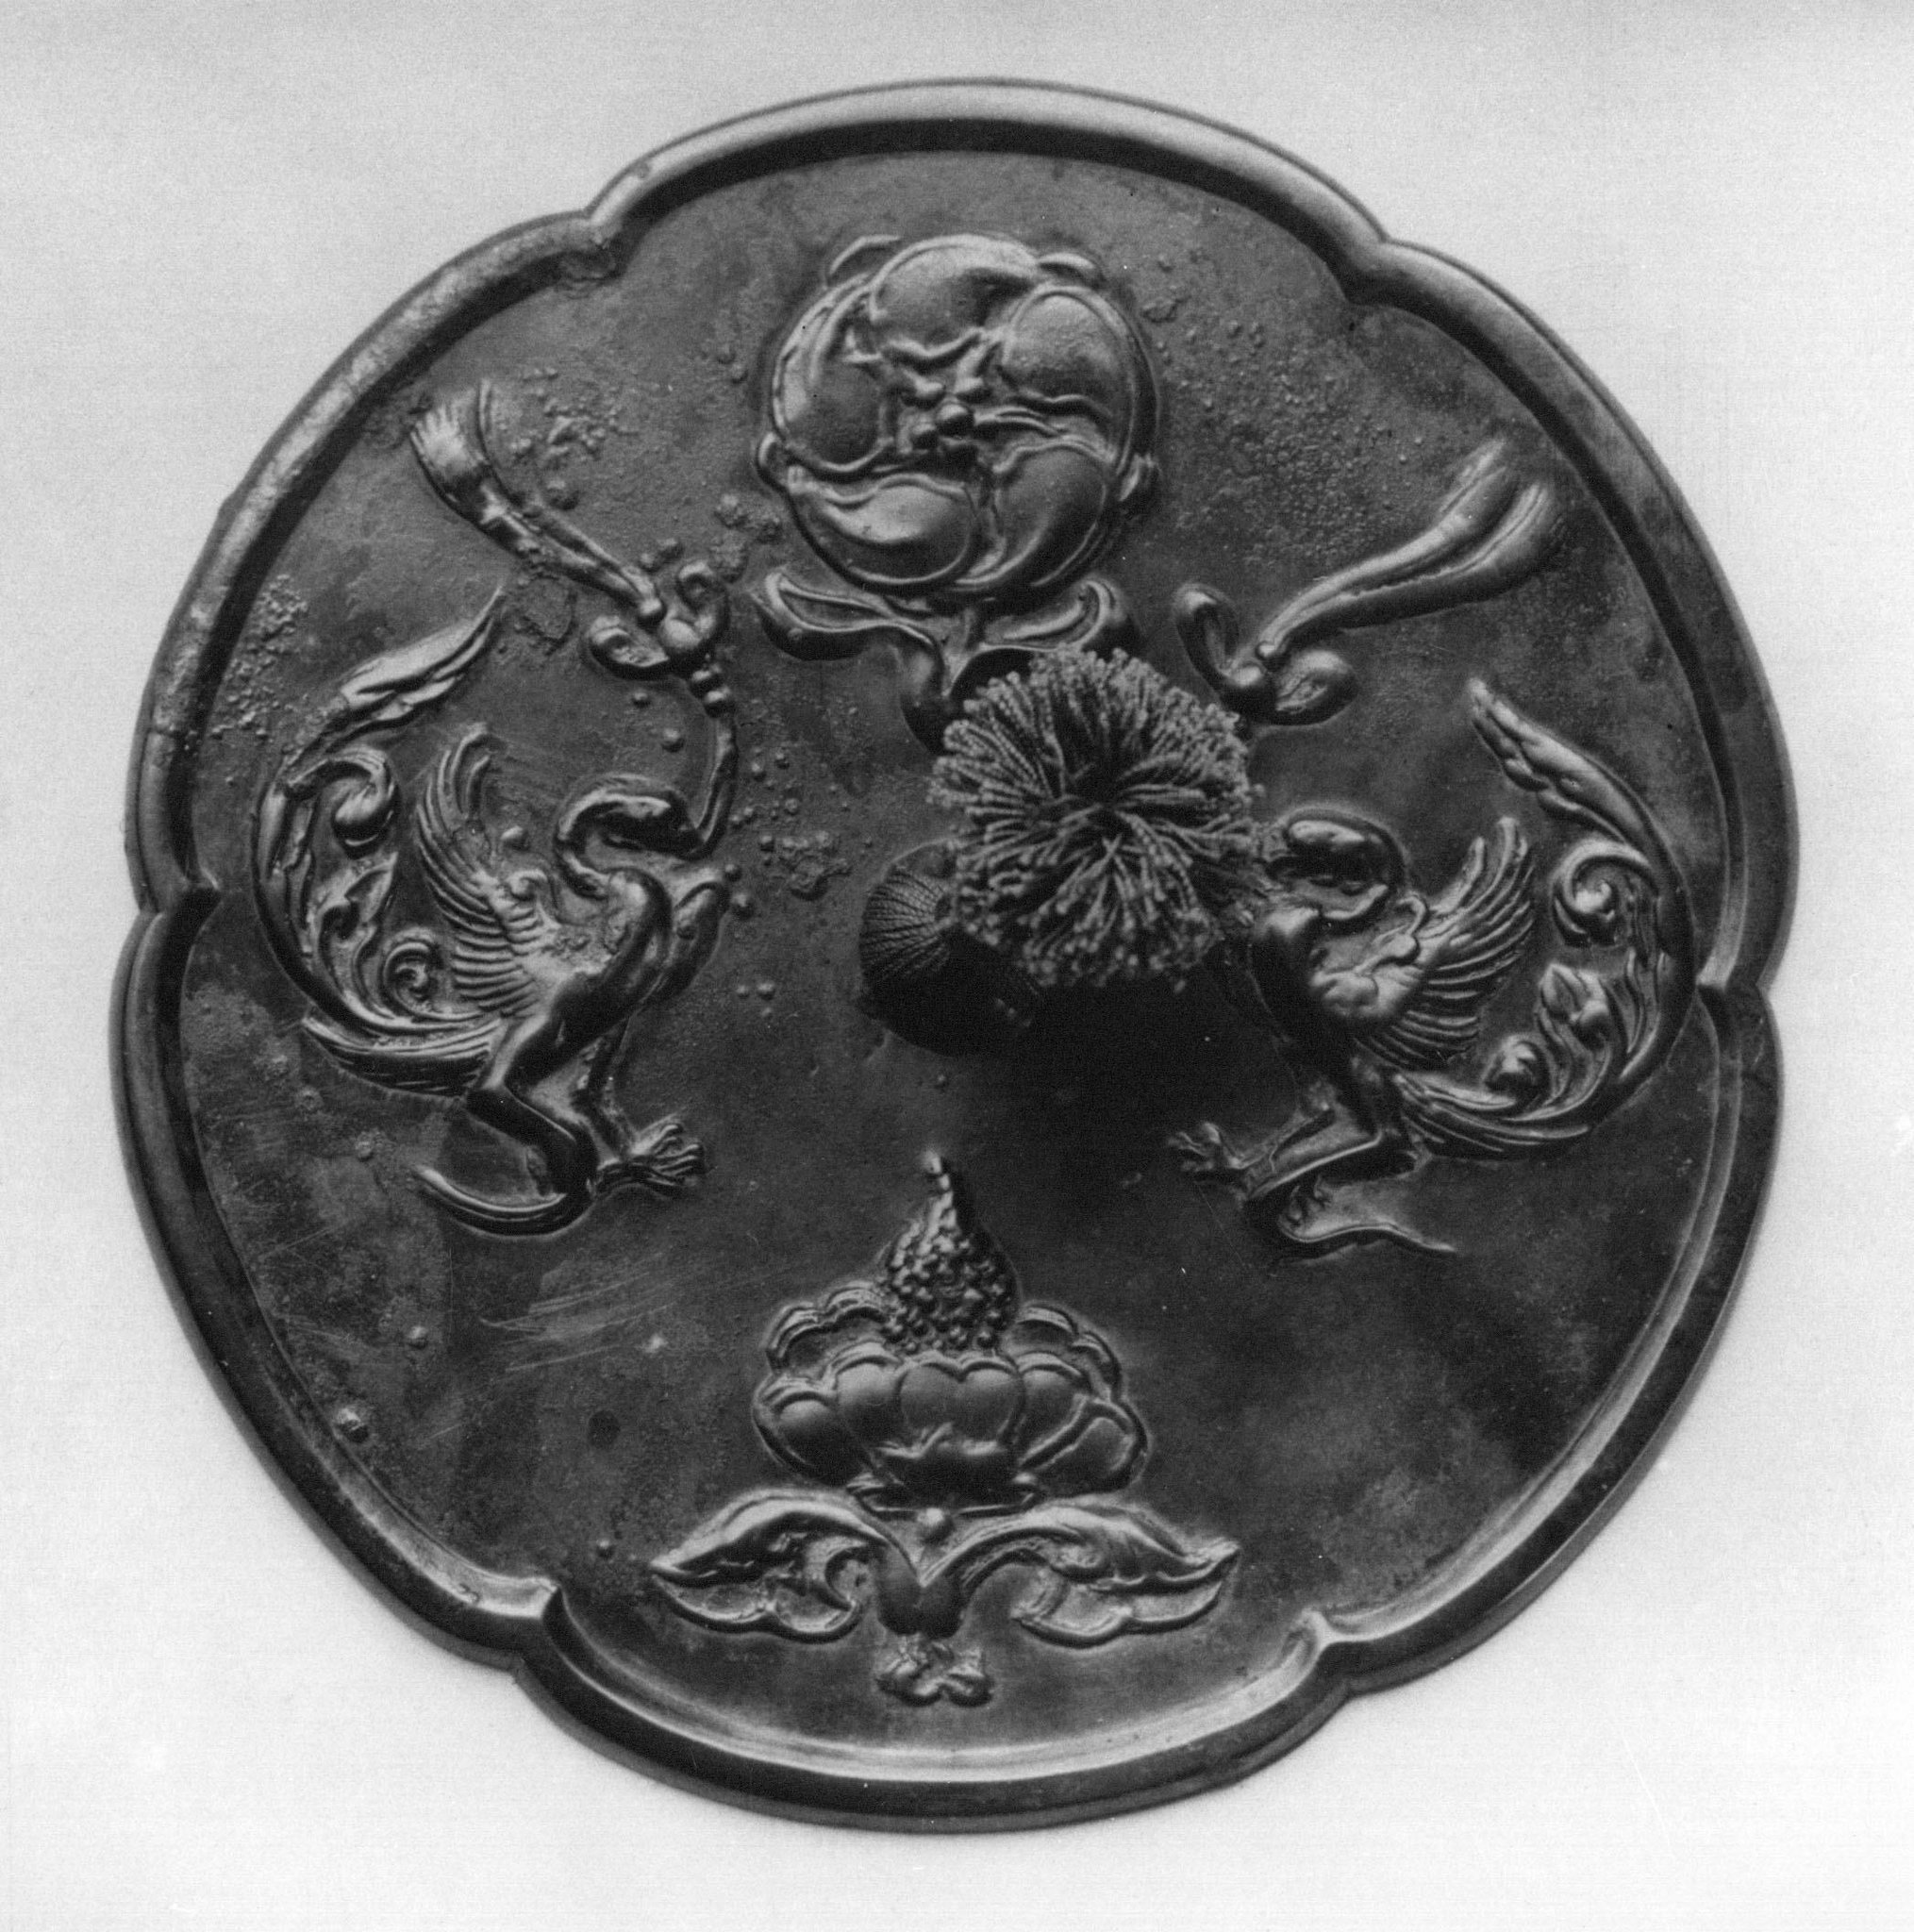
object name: mirror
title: Mirror with paired fantastic birds and floral designs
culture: chinese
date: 701-800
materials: bronze, patina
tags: birds